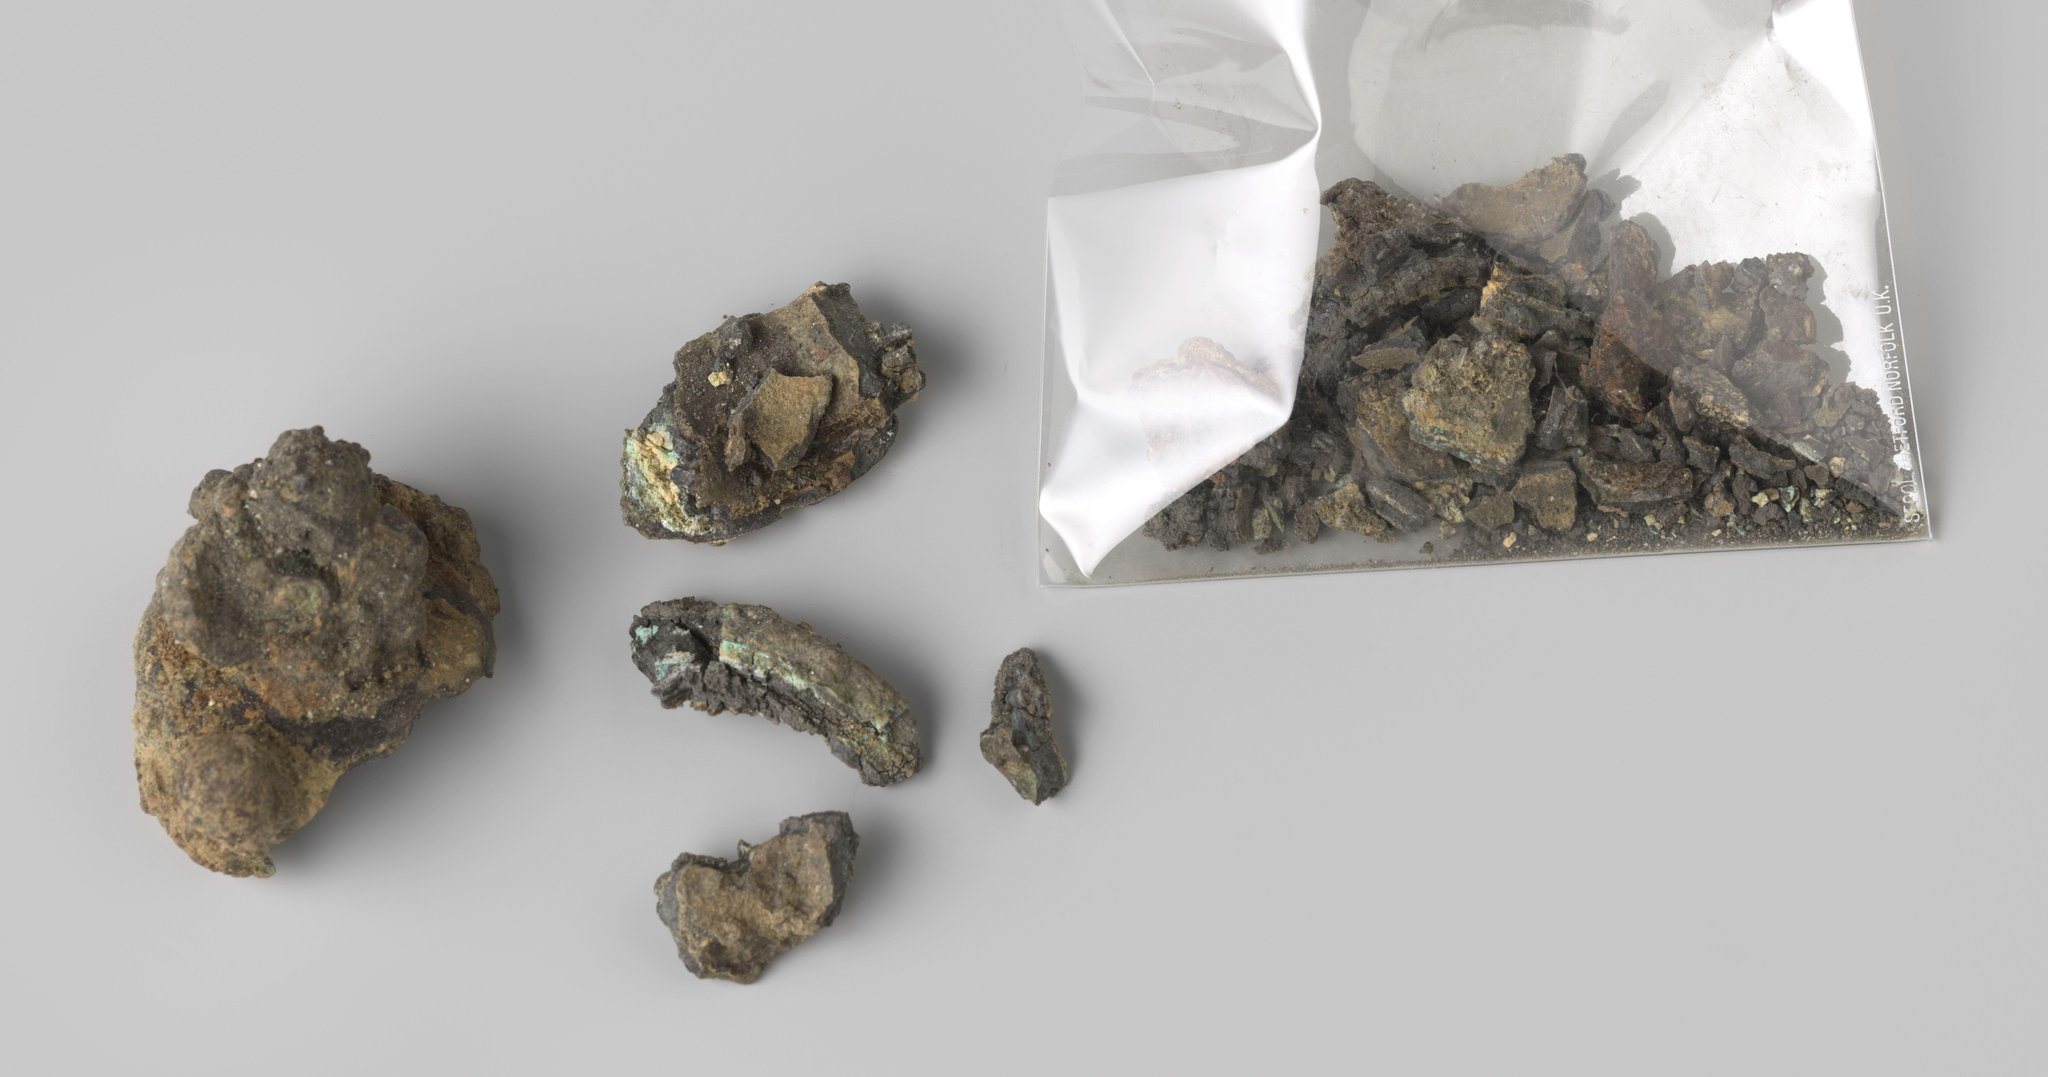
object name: screw in socket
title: Schroefdop en -fitting uit het wrak van de Oost-Indiëvaarder Hollandia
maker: Anonymous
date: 1700-1743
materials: tin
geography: netherlands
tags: verenigde oostindische compagnie, hollandia (schip), annet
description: Container, screw cap and fitting; fragm of stub and cap, id. NG 1980-27H2619 corroded.